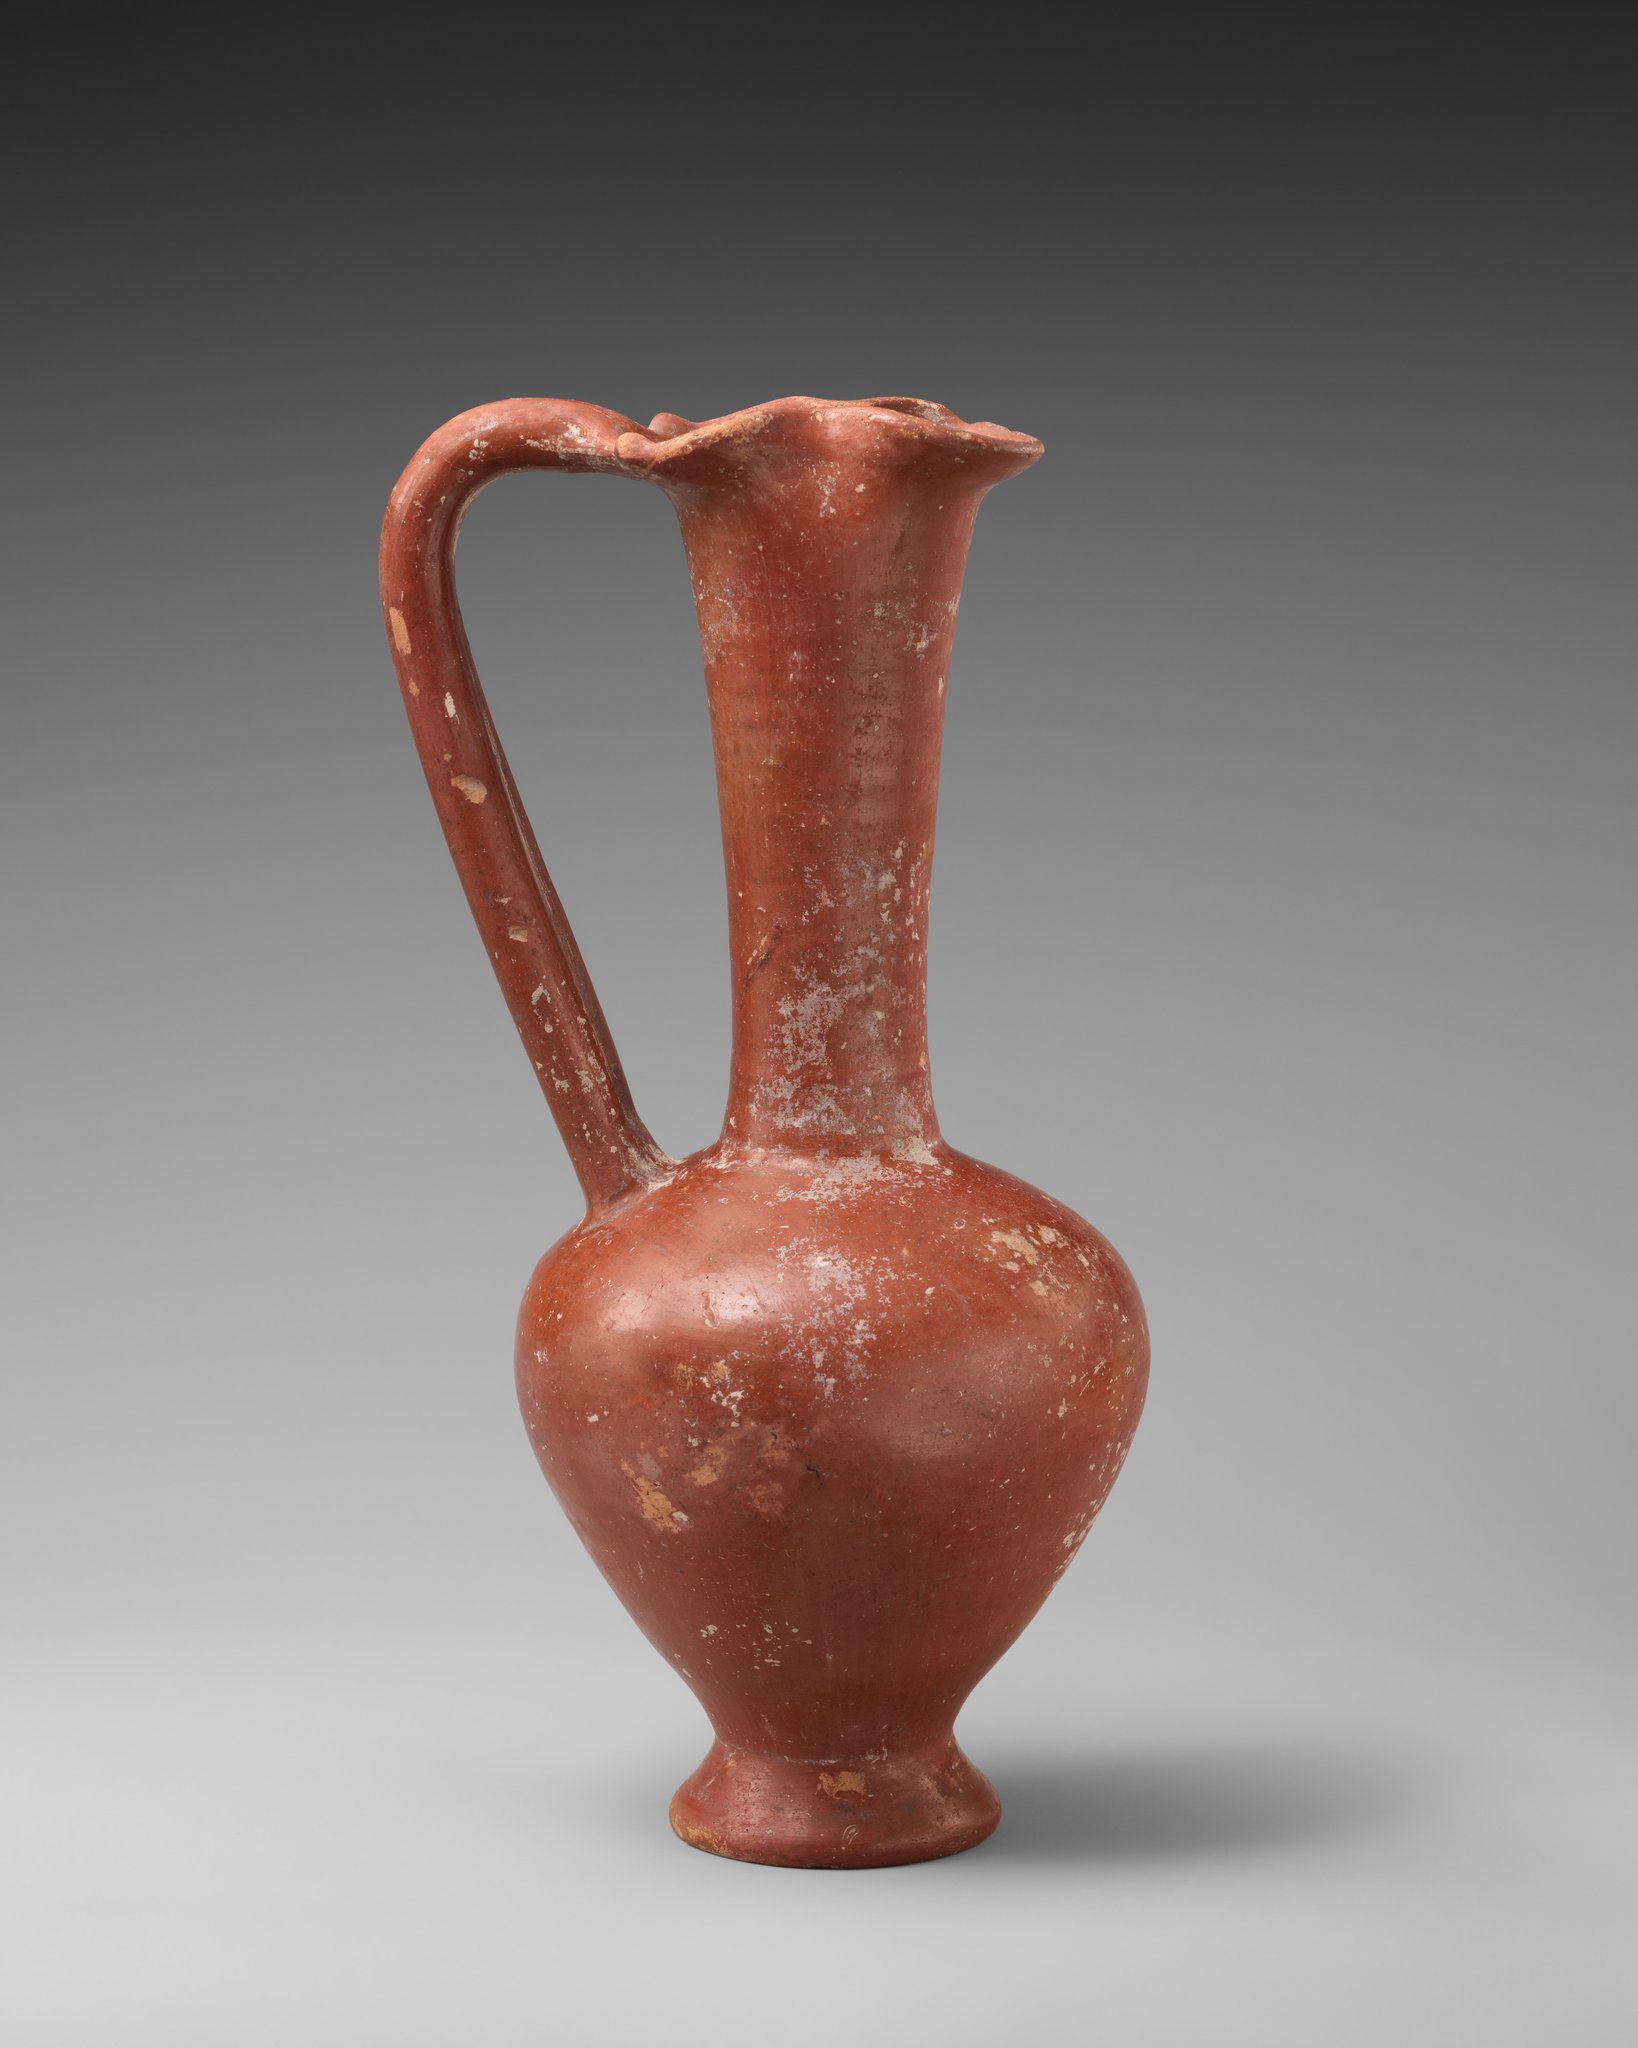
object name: jug, trefoil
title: Terracotta trefoil jug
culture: phoenician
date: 700-601 BCE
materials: terracotta